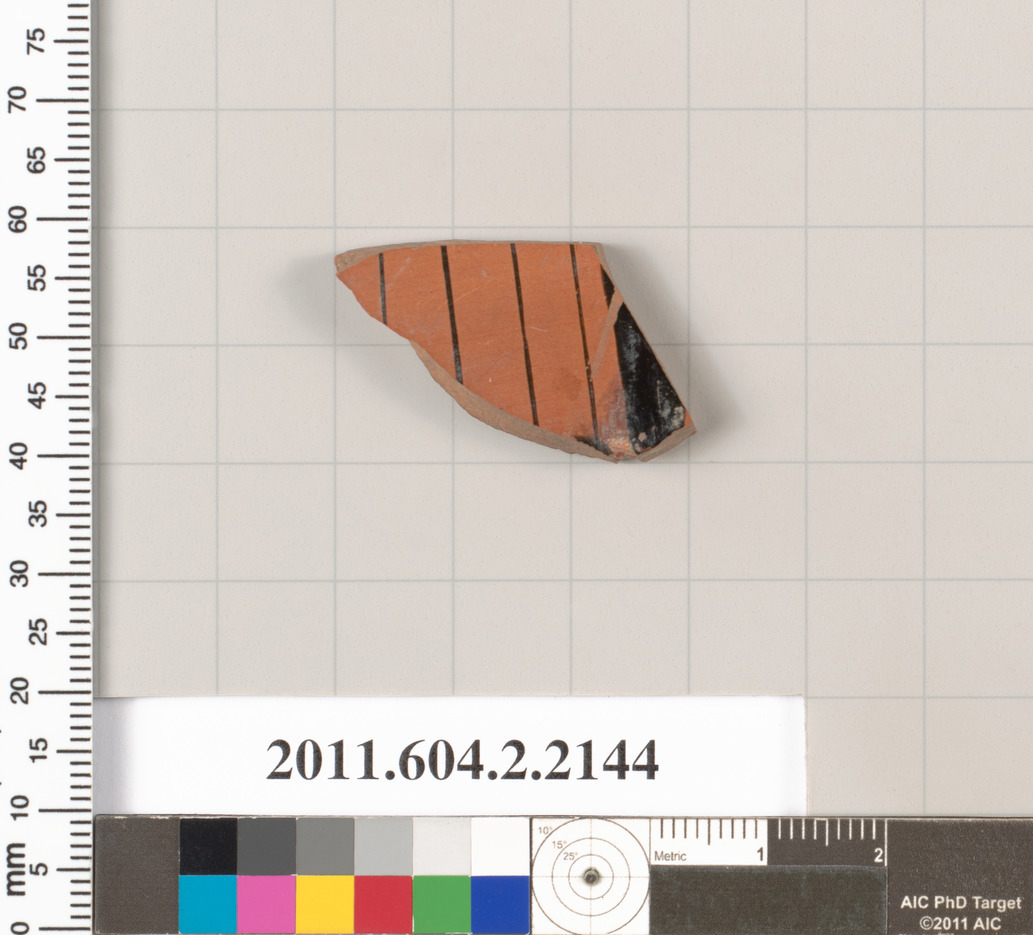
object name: krater fragment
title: Terracotta fragment of a column-krater (bowl for mixing wine and water)?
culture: greek, attic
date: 475-451 BCE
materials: terracotta